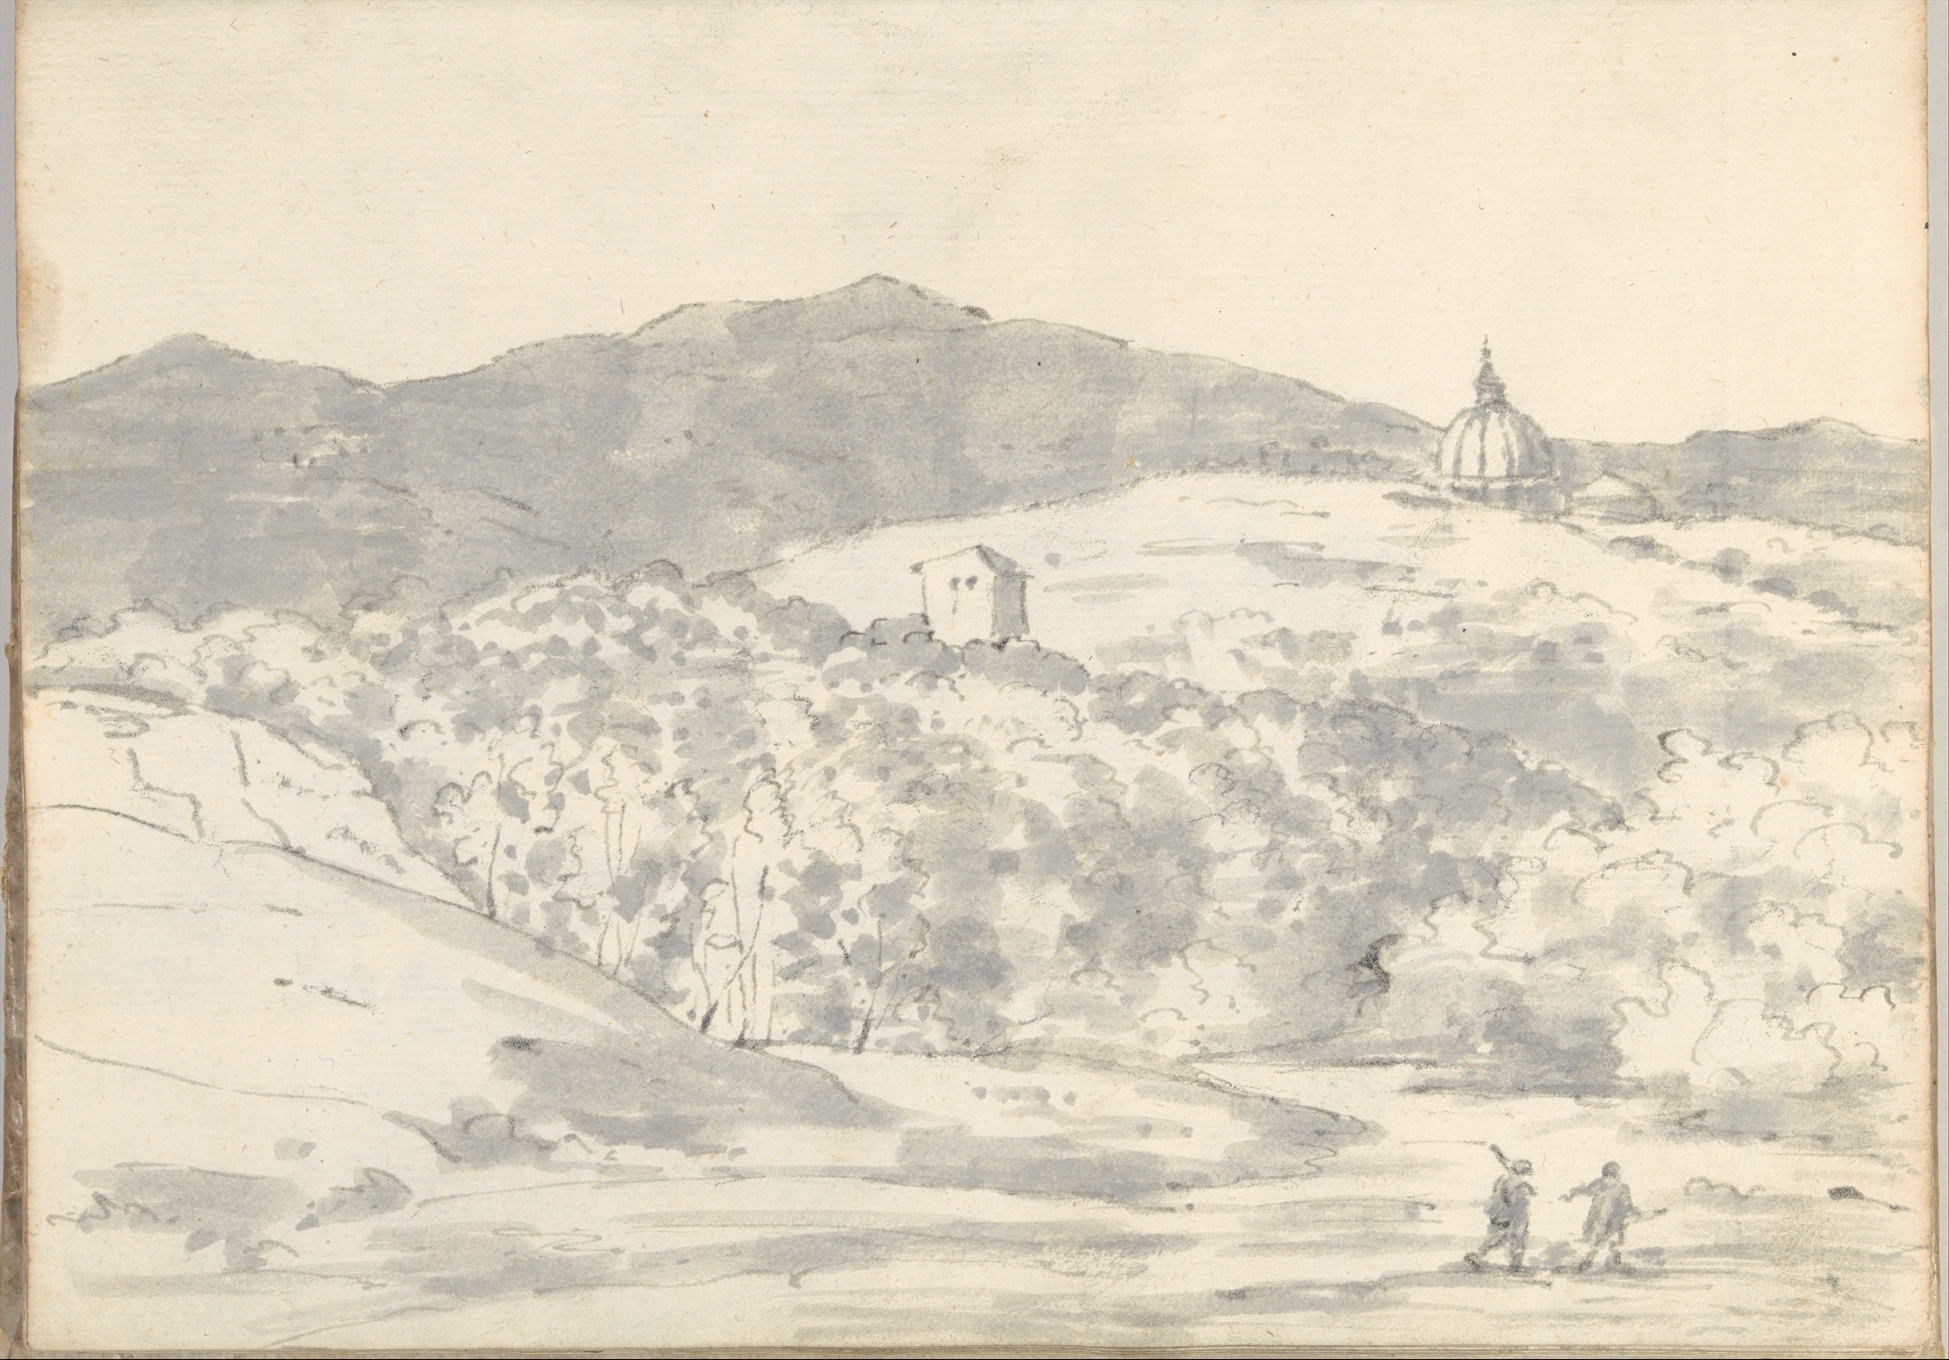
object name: drawing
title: Landscape with a towered building and domed church, near Rome (Smaller Italian sketchbook, leaf 32 recto)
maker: joseph wright (wright of derby)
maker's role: artist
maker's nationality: british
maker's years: 1734-1797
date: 1774-1775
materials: ink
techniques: brush, pen, wash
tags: landscapes